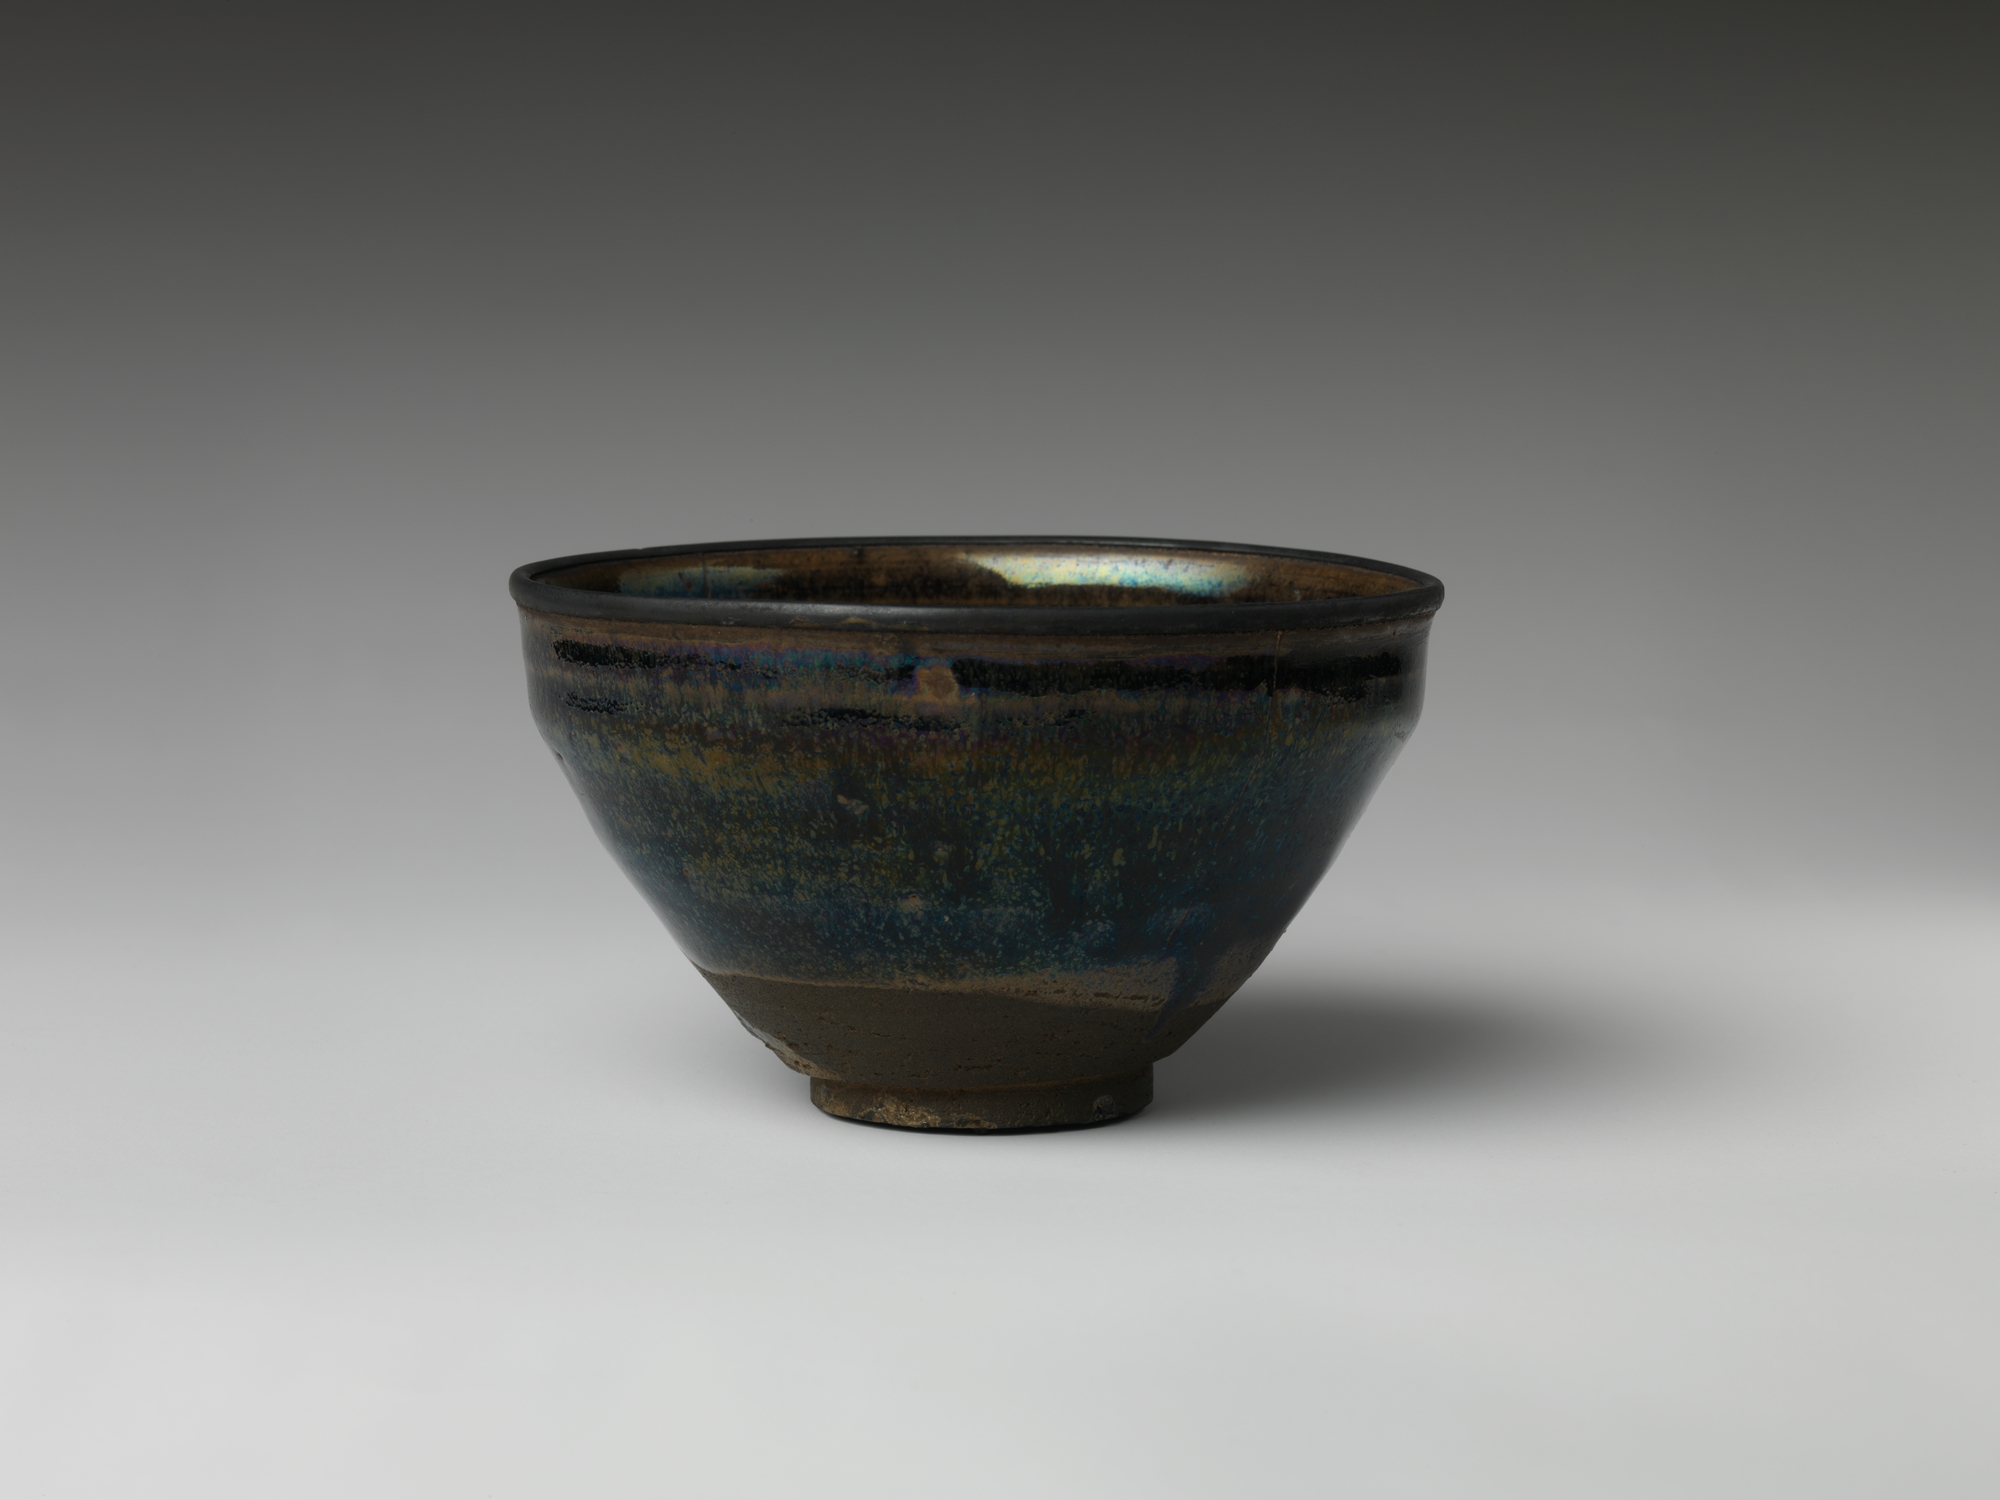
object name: teabowl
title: Teabowl (Chawan)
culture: japanese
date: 1701-1800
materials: glaze, iron, stoneware